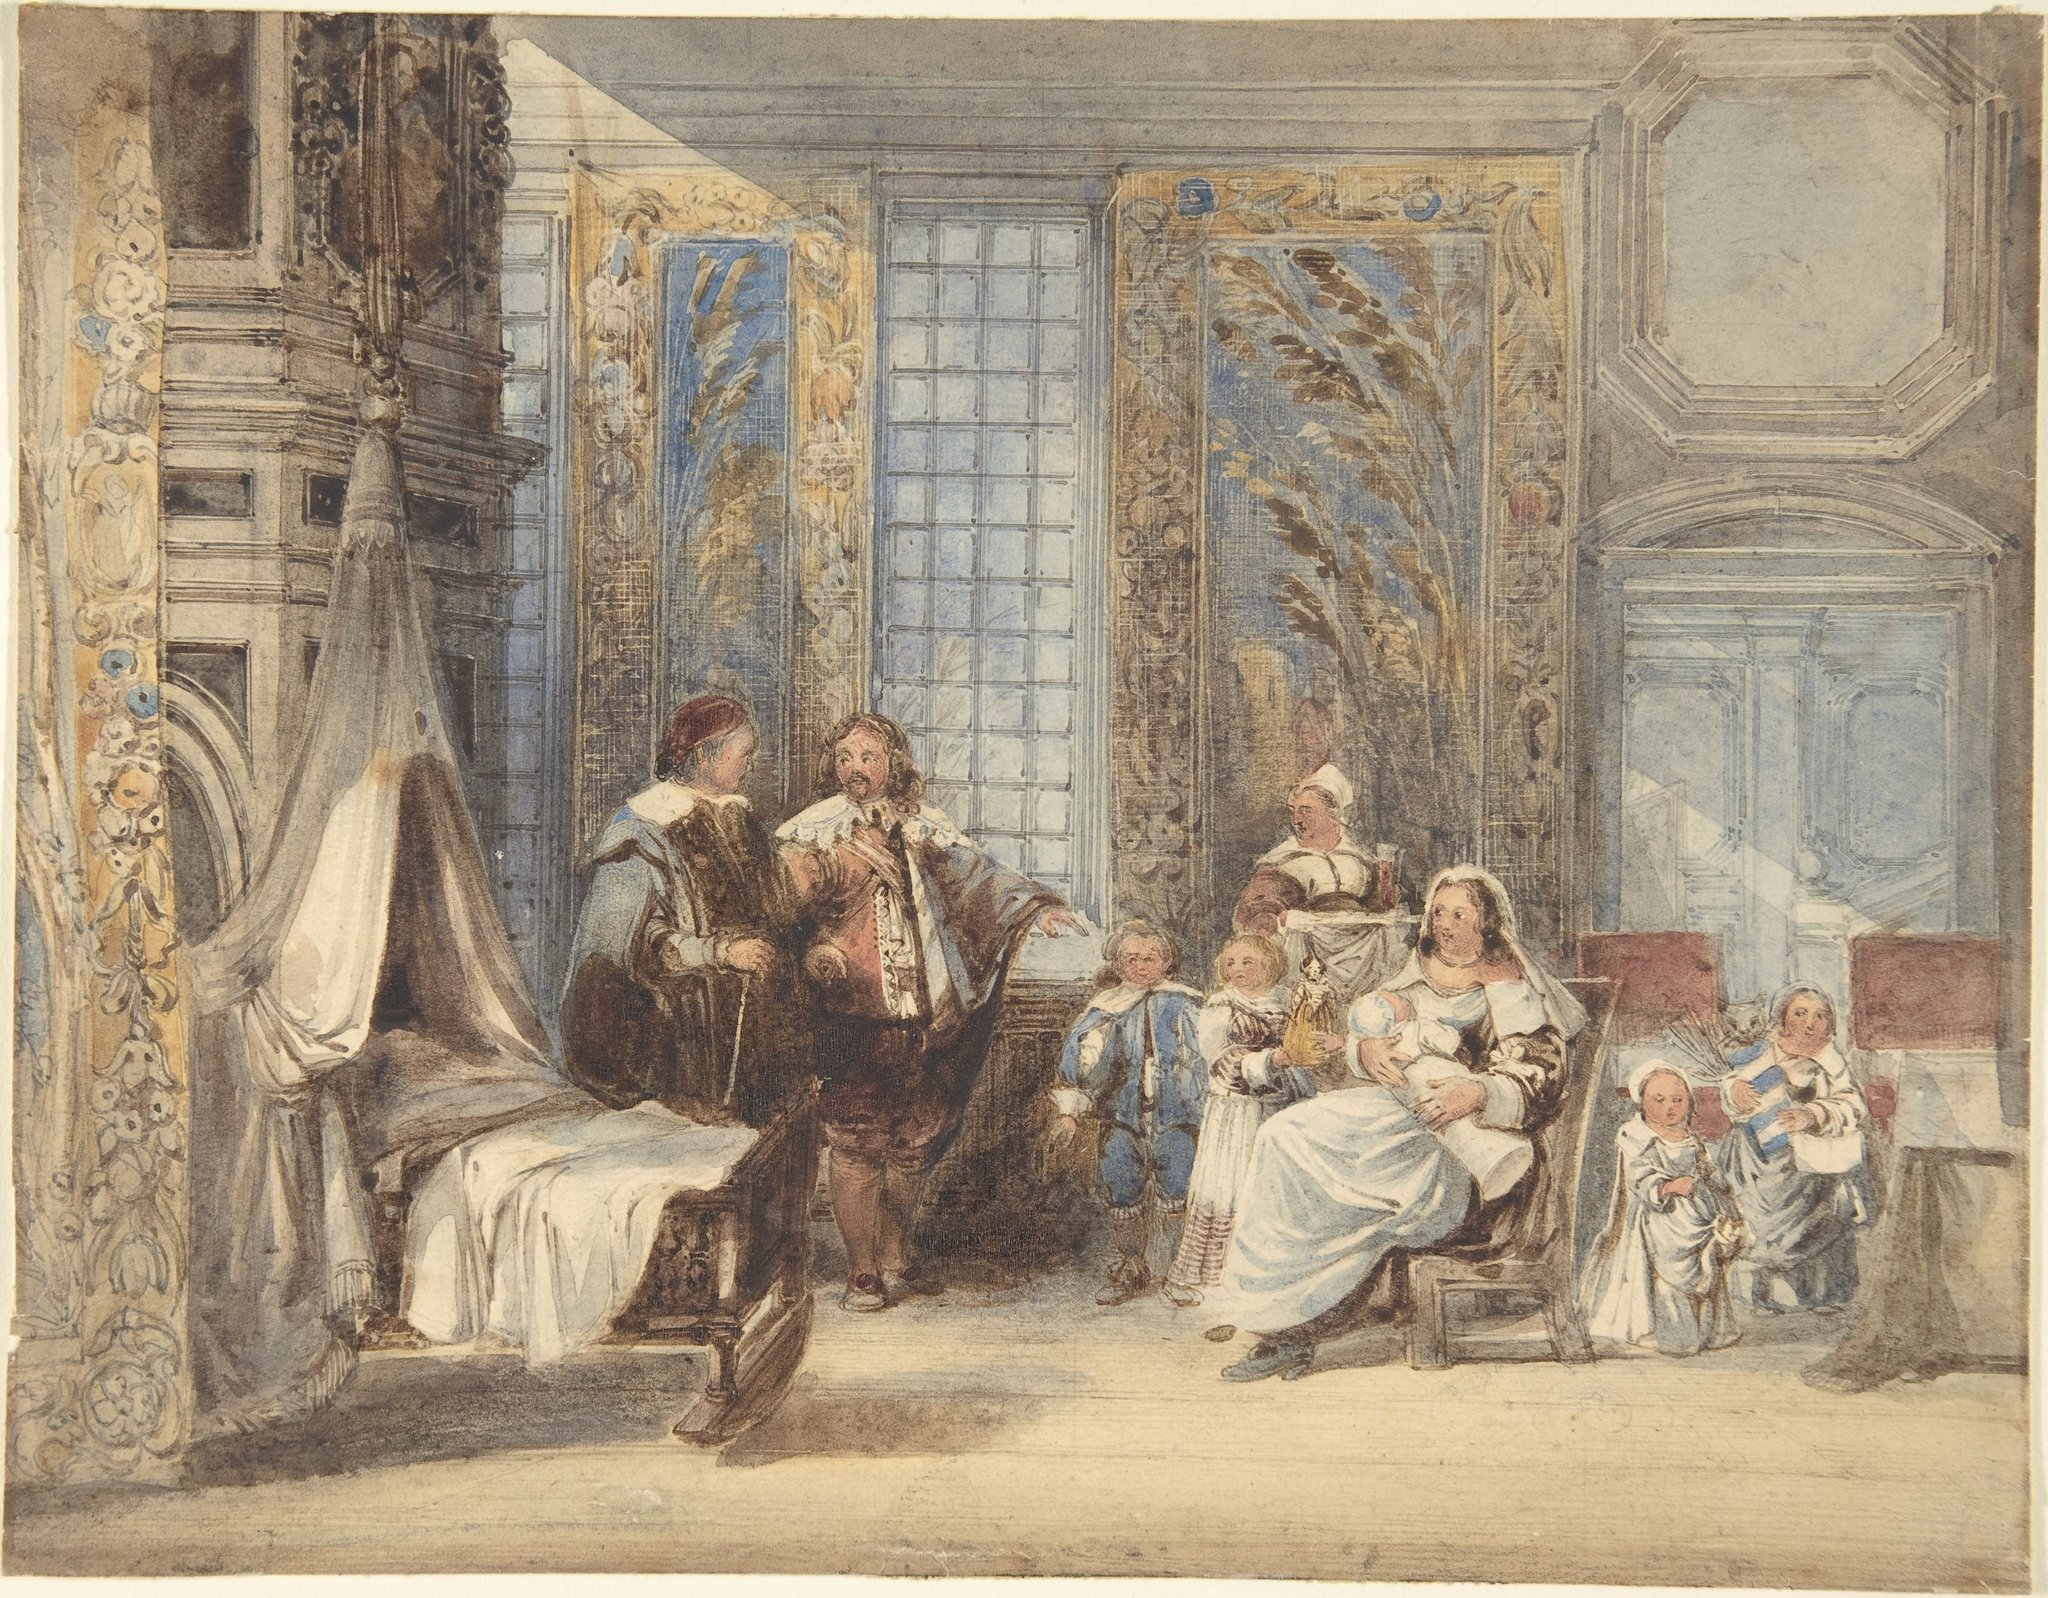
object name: drawing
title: Scene with Family and Guest in Seventeenth-Century Interior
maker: joseph nash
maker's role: artist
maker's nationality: british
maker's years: 1809-1878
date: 1825-1878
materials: graphite, watercolor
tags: interiors,children,men,women,family